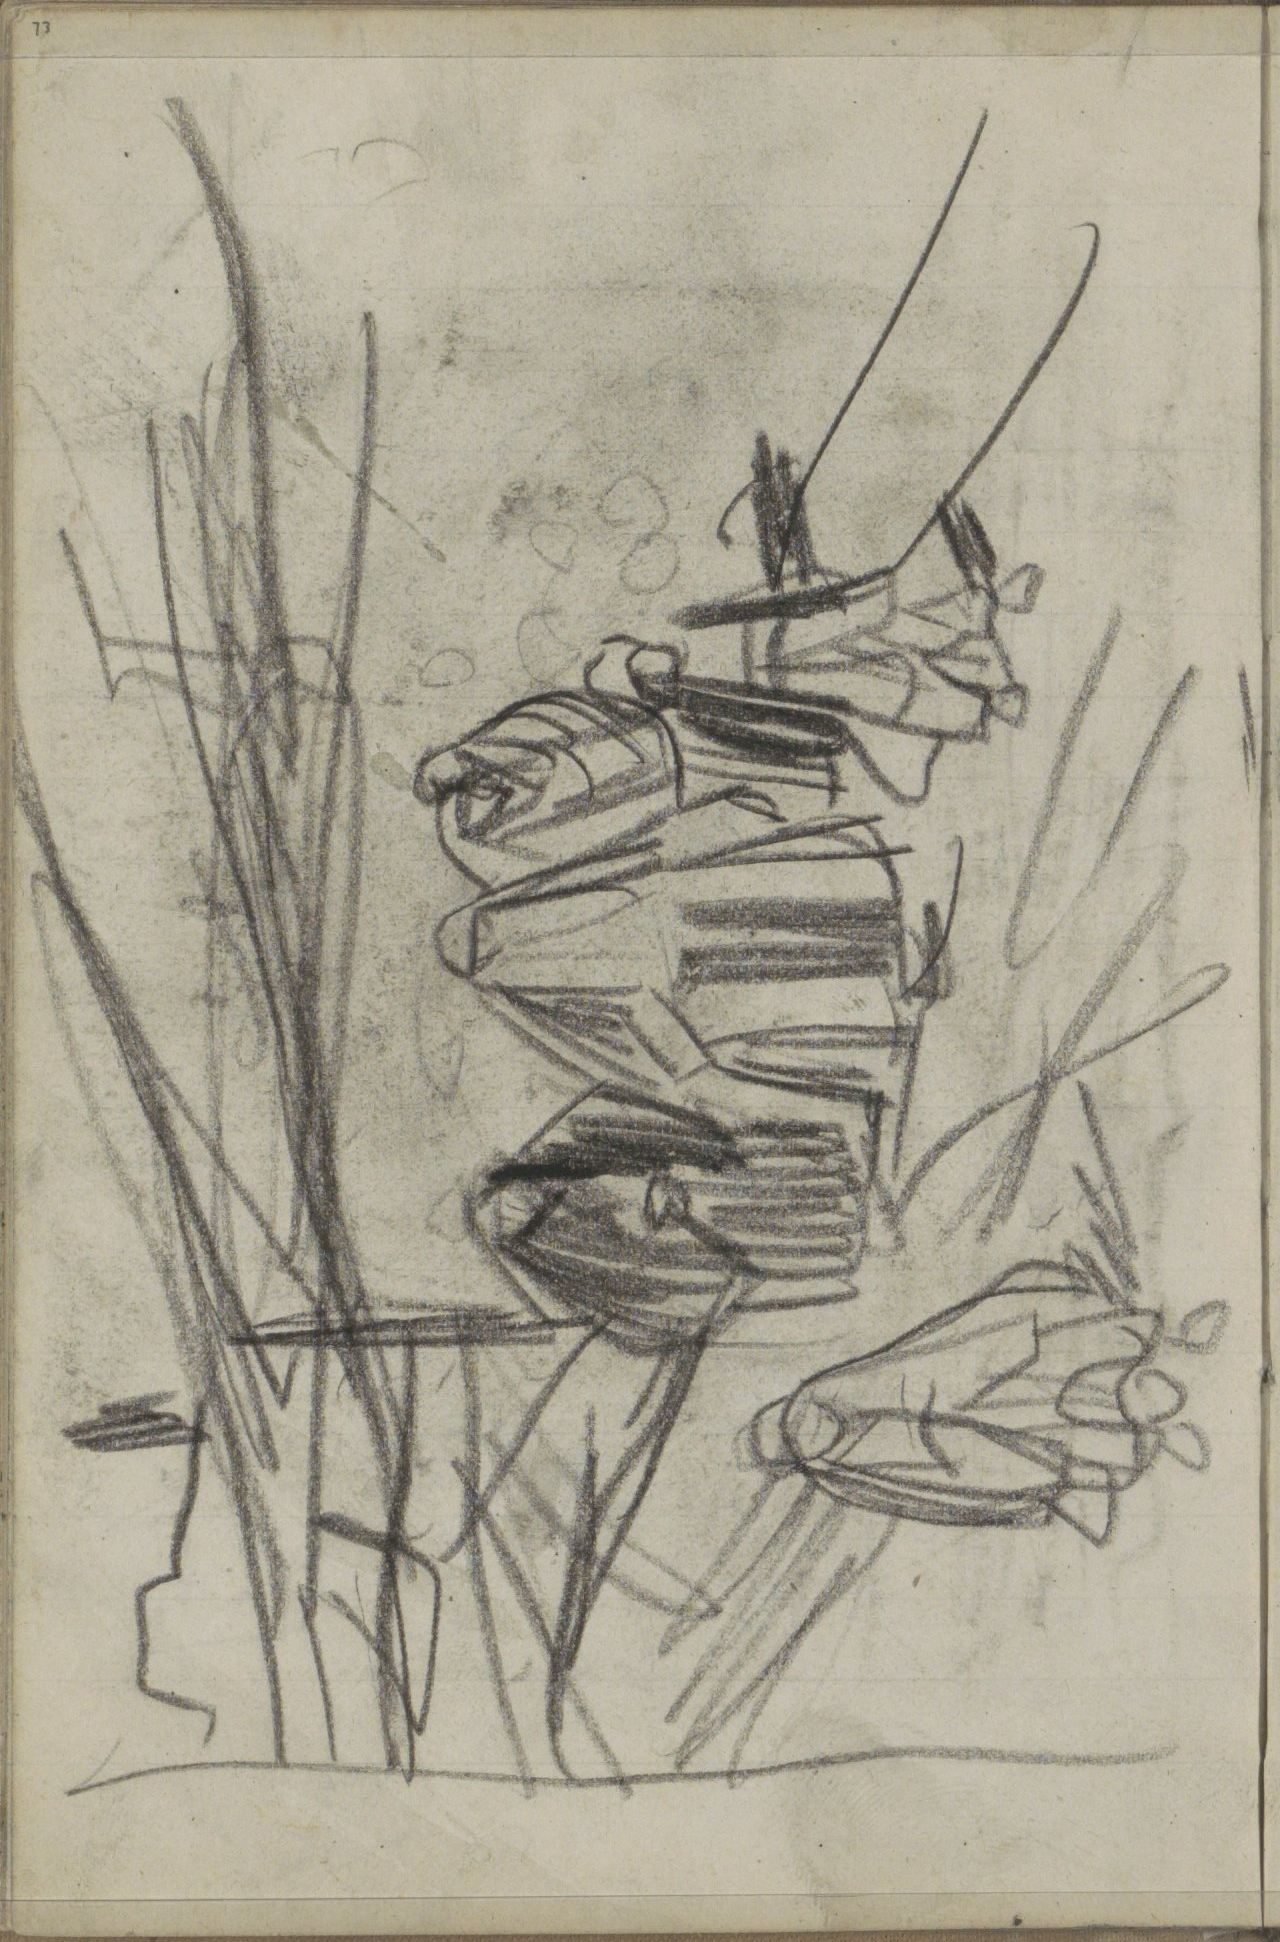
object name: sketchbook leaf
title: Figuren in oosterse kleding op een weg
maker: marius bauer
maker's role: draughtsman, print maker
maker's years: 1867-1932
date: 1888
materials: chalk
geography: istanbul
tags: asiatic races and peoples, road, path, walking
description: Pagina 73 uit een schetsboek met 56 bladen.